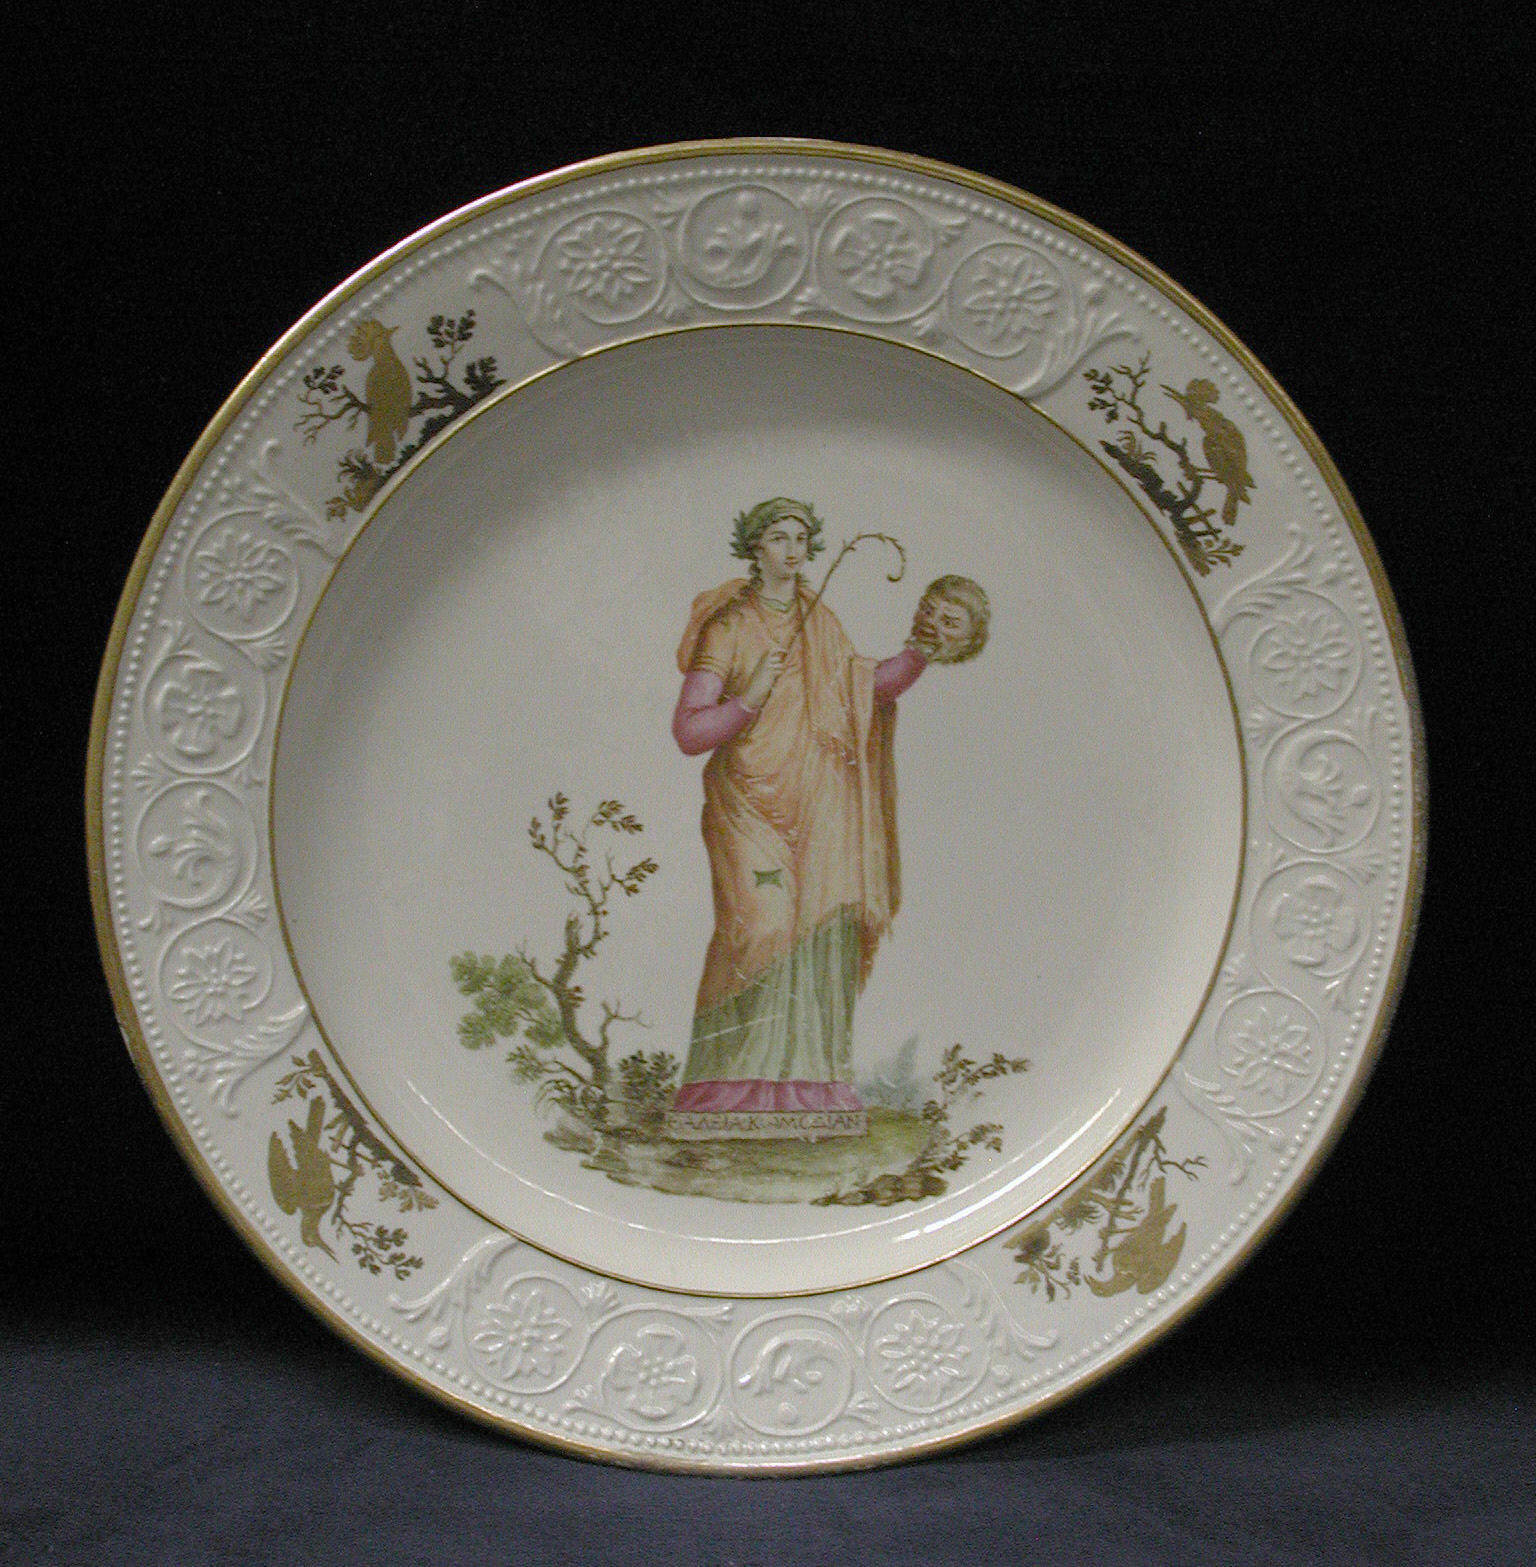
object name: plate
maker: royal porcelain manufactory, naples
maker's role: manufactory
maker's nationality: italian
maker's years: 1759-1819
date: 1780-1782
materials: soft paste porcelain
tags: human figures,birds,heads